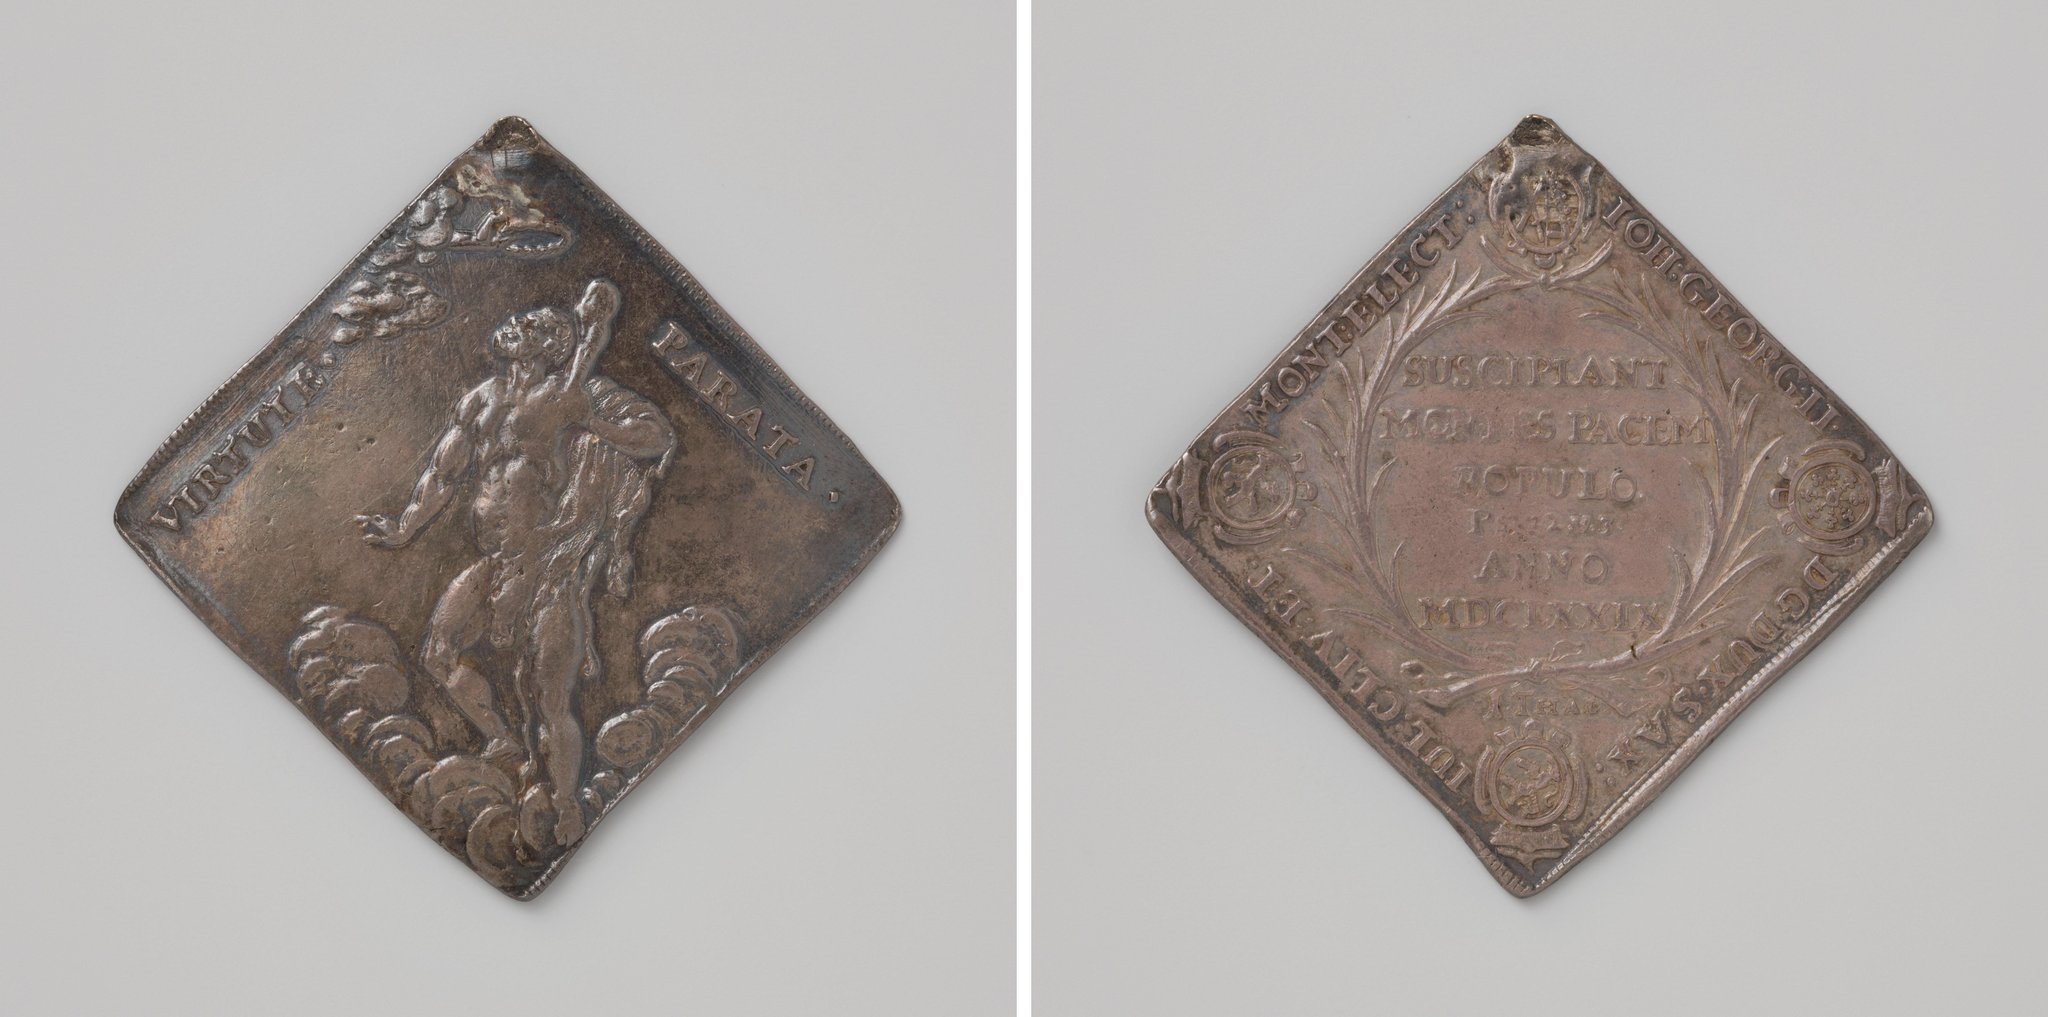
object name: taler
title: Penning of taler over de Vrede van Nijmegen, ter ere van Johan George II, keurvorst van Saksen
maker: Anonymous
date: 1679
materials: silver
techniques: striking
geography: germany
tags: nijmegen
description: Zilveren rechthoekige penning of munt. Voorzijde: opschrift binnen krans van palmtakken, daaromheen omschrift tussen vier wapenschilden. Keerzijde: Hercules ontvangt lauwerkrans uit de hemel binnen omschrift.